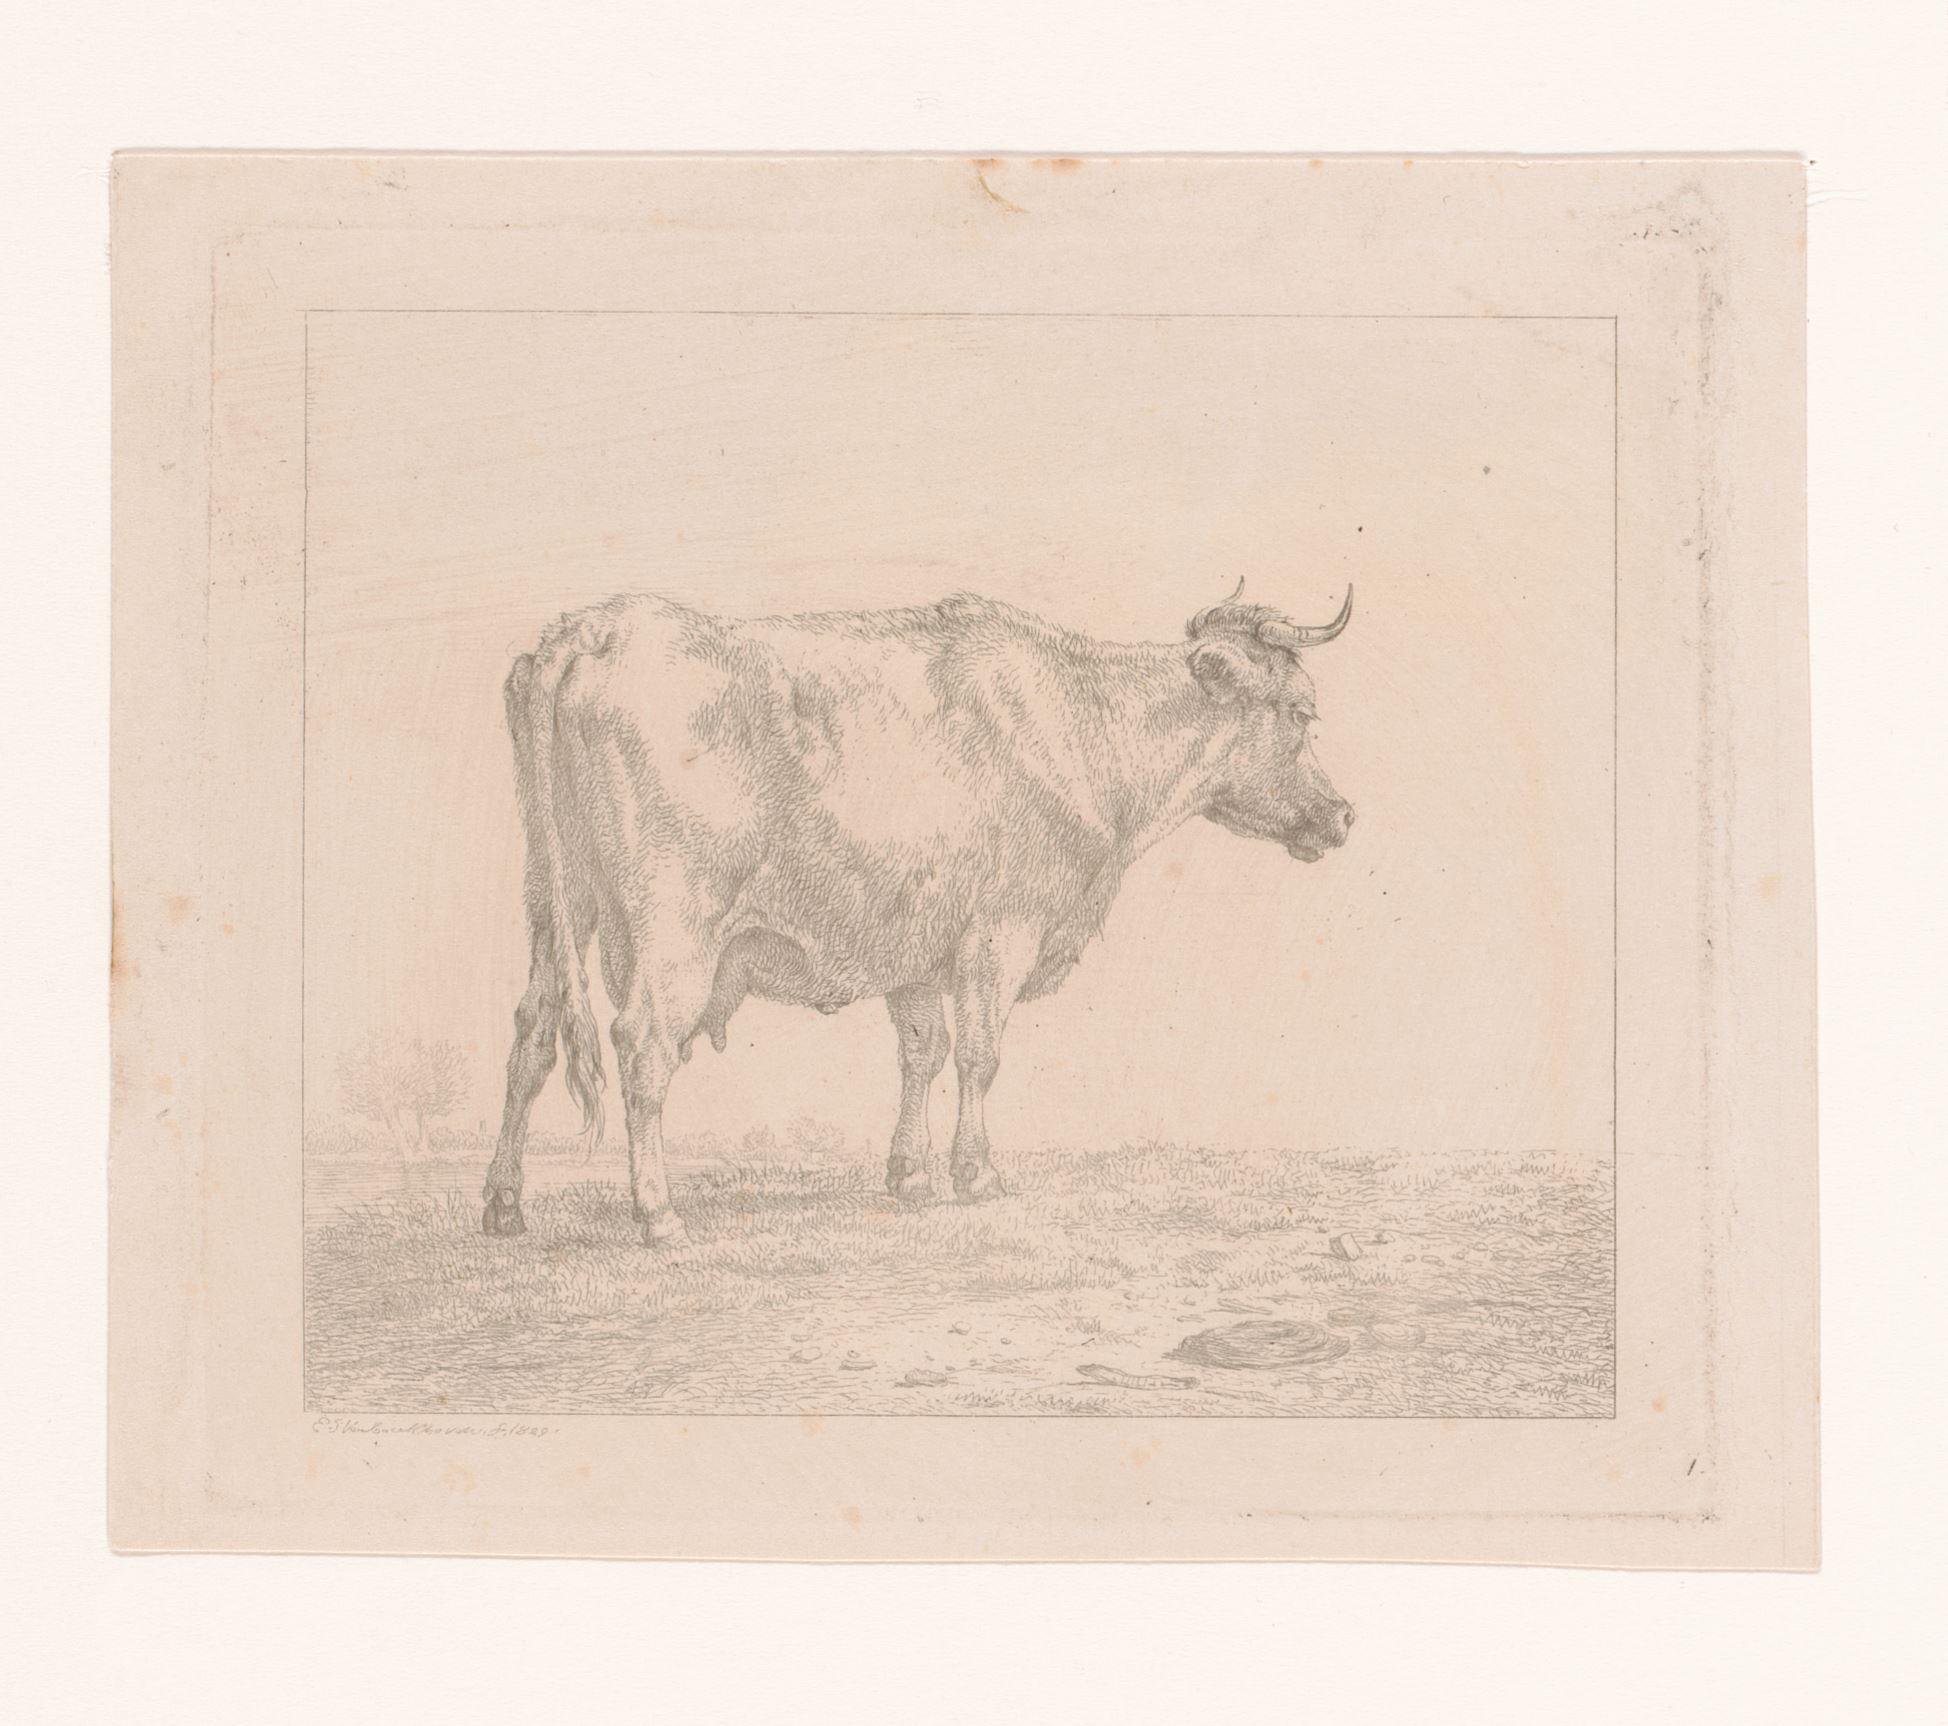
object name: print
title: Koe in een wei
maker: eugène verboeckhoven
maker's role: draughtsman, painter, print maker, printer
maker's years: 1798-1881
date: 1829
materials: paper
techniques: etching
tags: cow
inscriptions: date